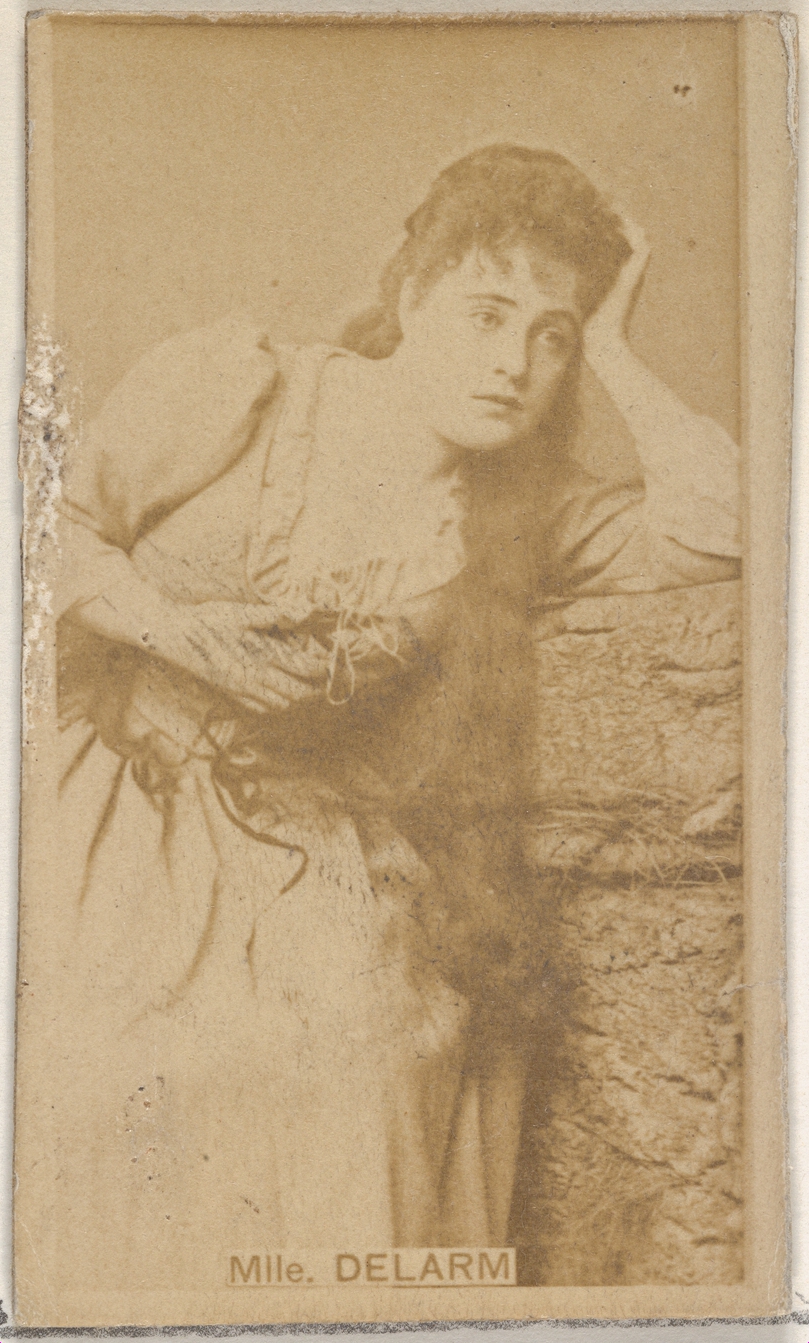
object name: photograph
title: Mlle. Delarme, from the Actors and Actresses series (N45, Type 8) for Virginia Brights Cigarettes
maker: allen & ginter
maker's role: publisher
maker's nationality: american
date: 1888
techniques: albumen silver print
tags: portraits,women,actresses